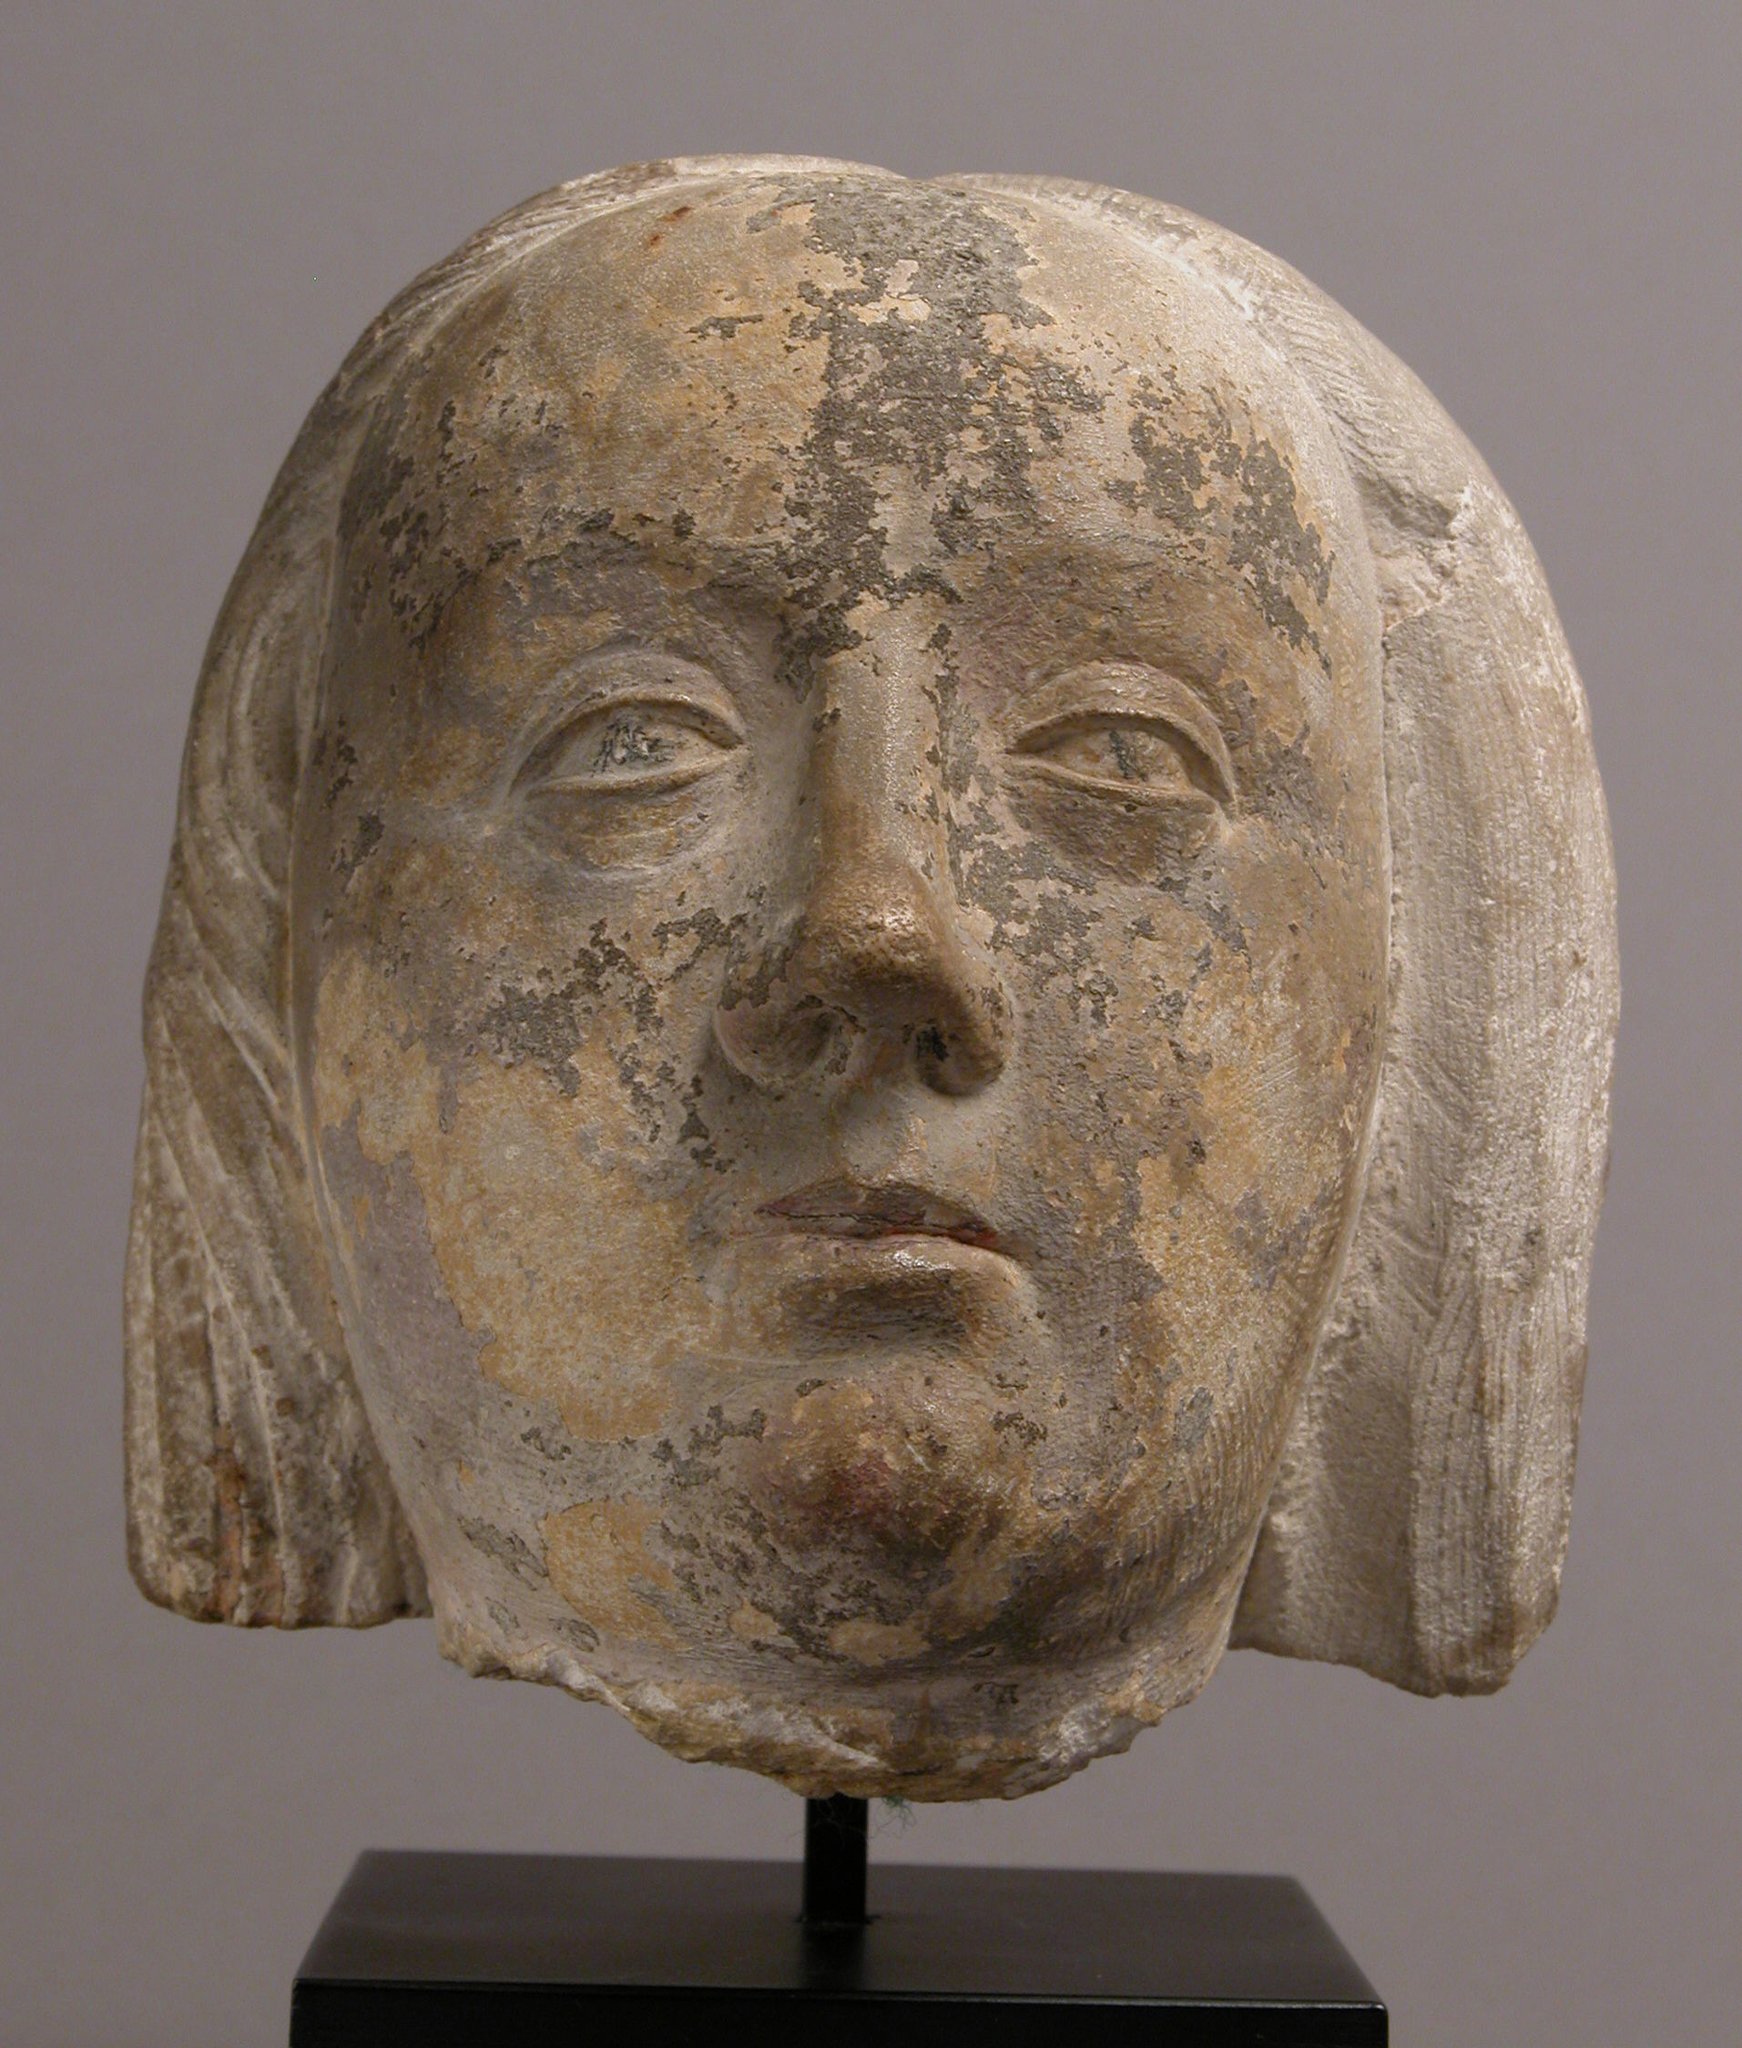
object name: statue head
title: Head of a Woman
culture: french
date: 1500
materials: limestone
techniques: polychromy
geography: troyes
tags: women